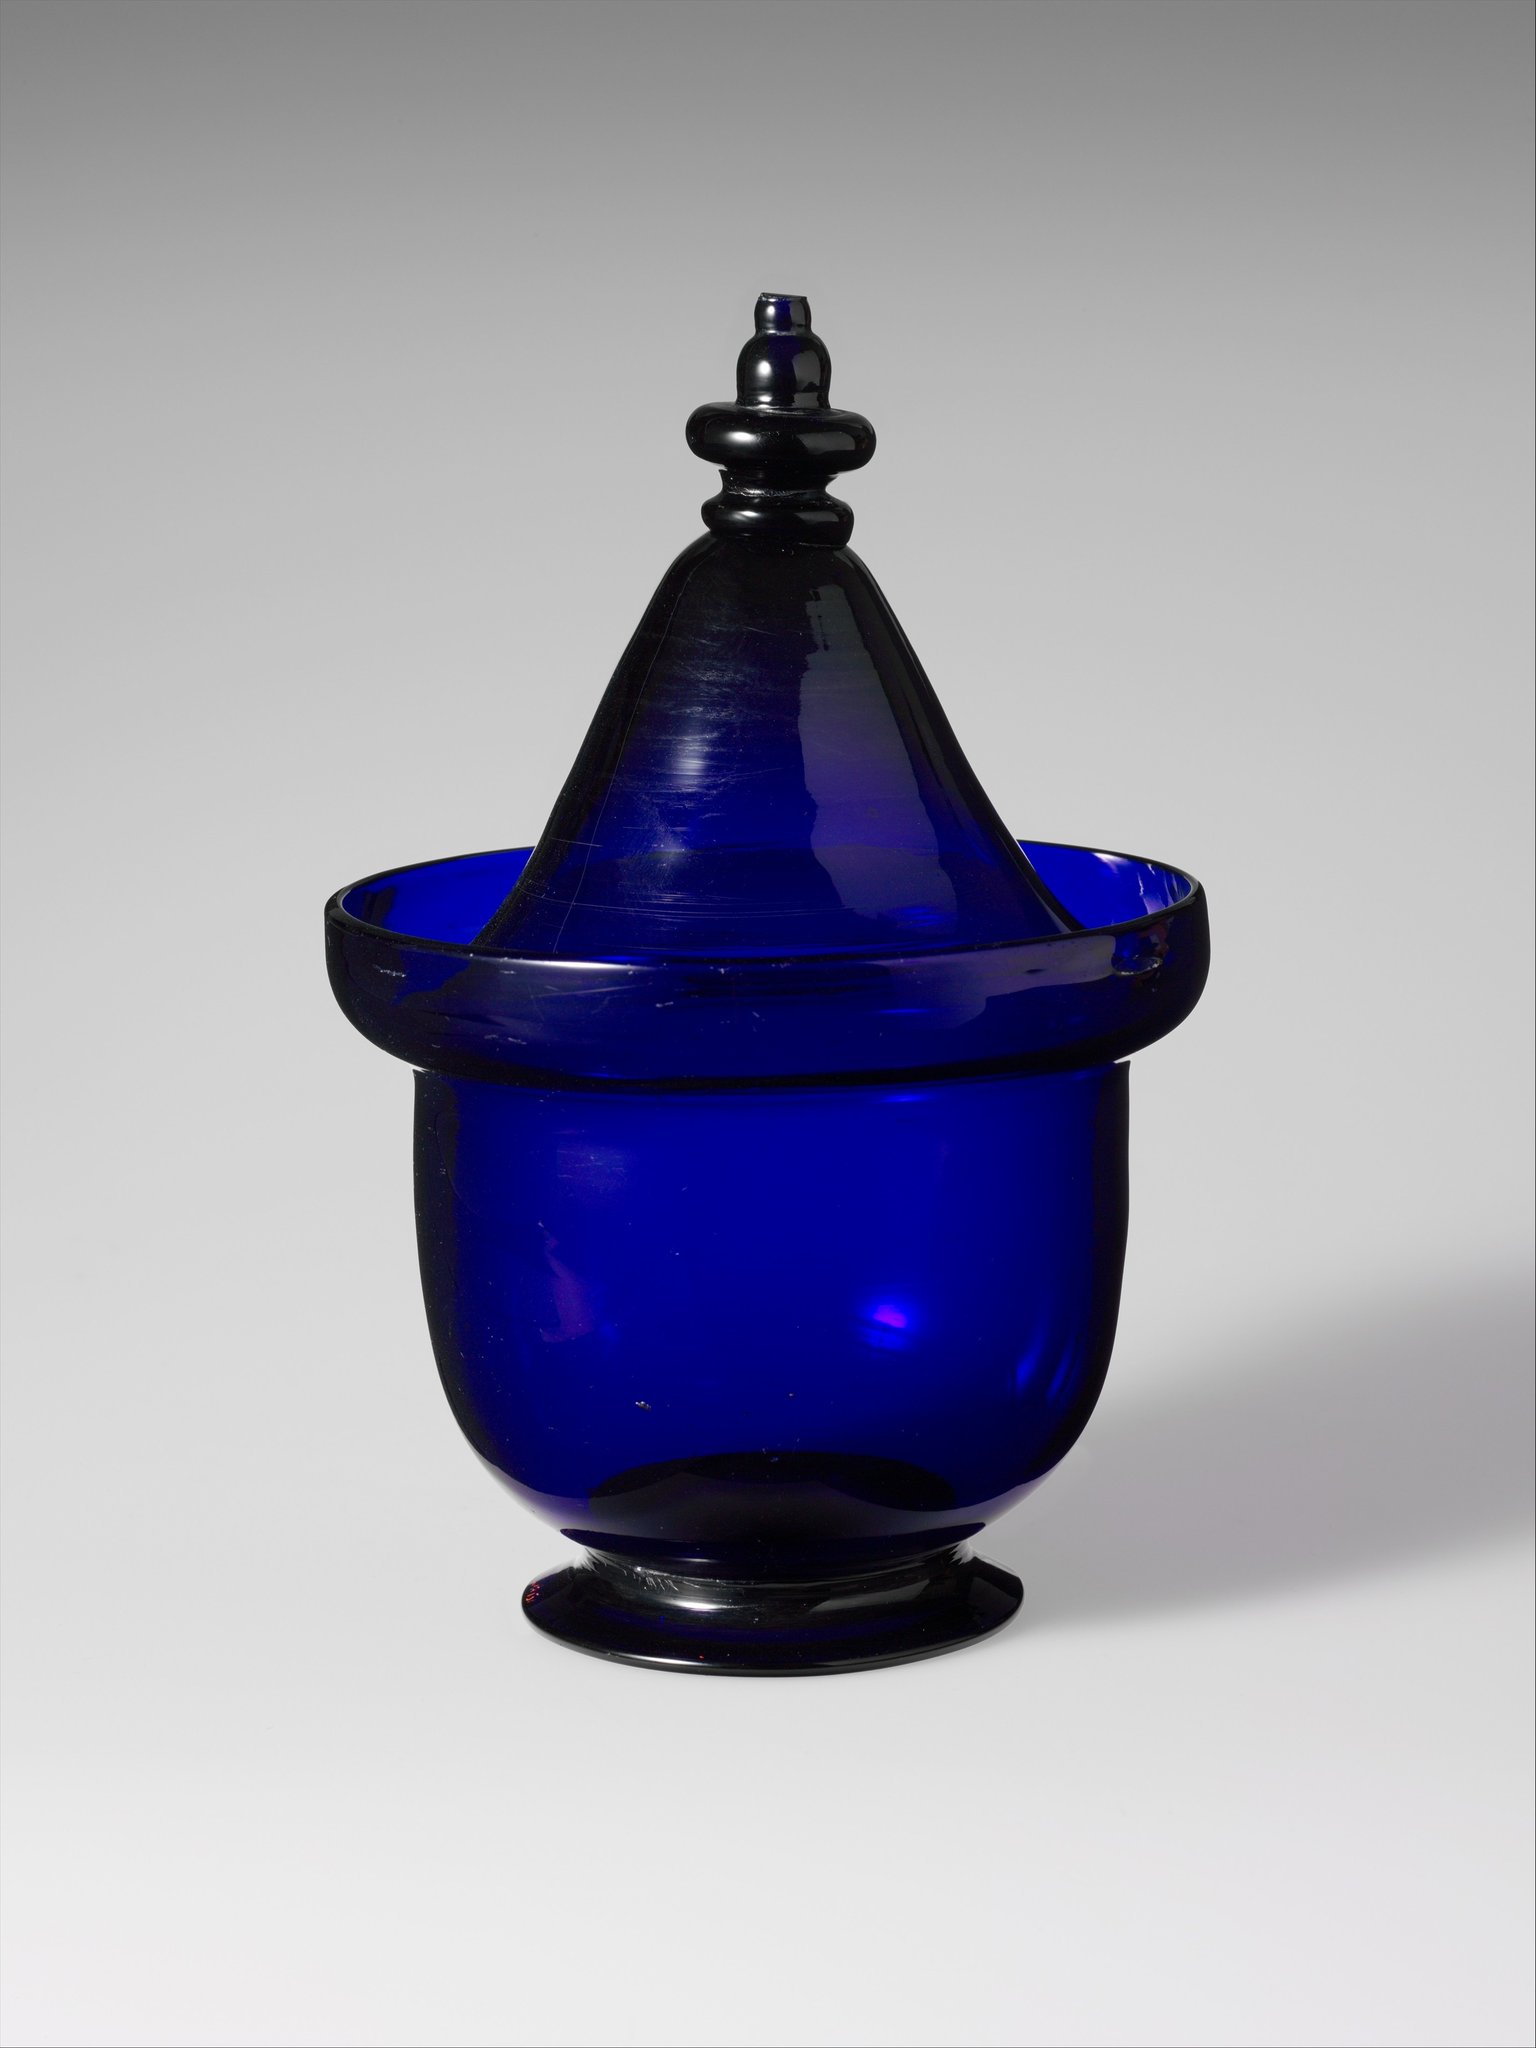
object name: sugar bowl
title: Covered Sugar Bowl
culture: american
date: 1800-1830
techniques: glassblowing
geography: united states